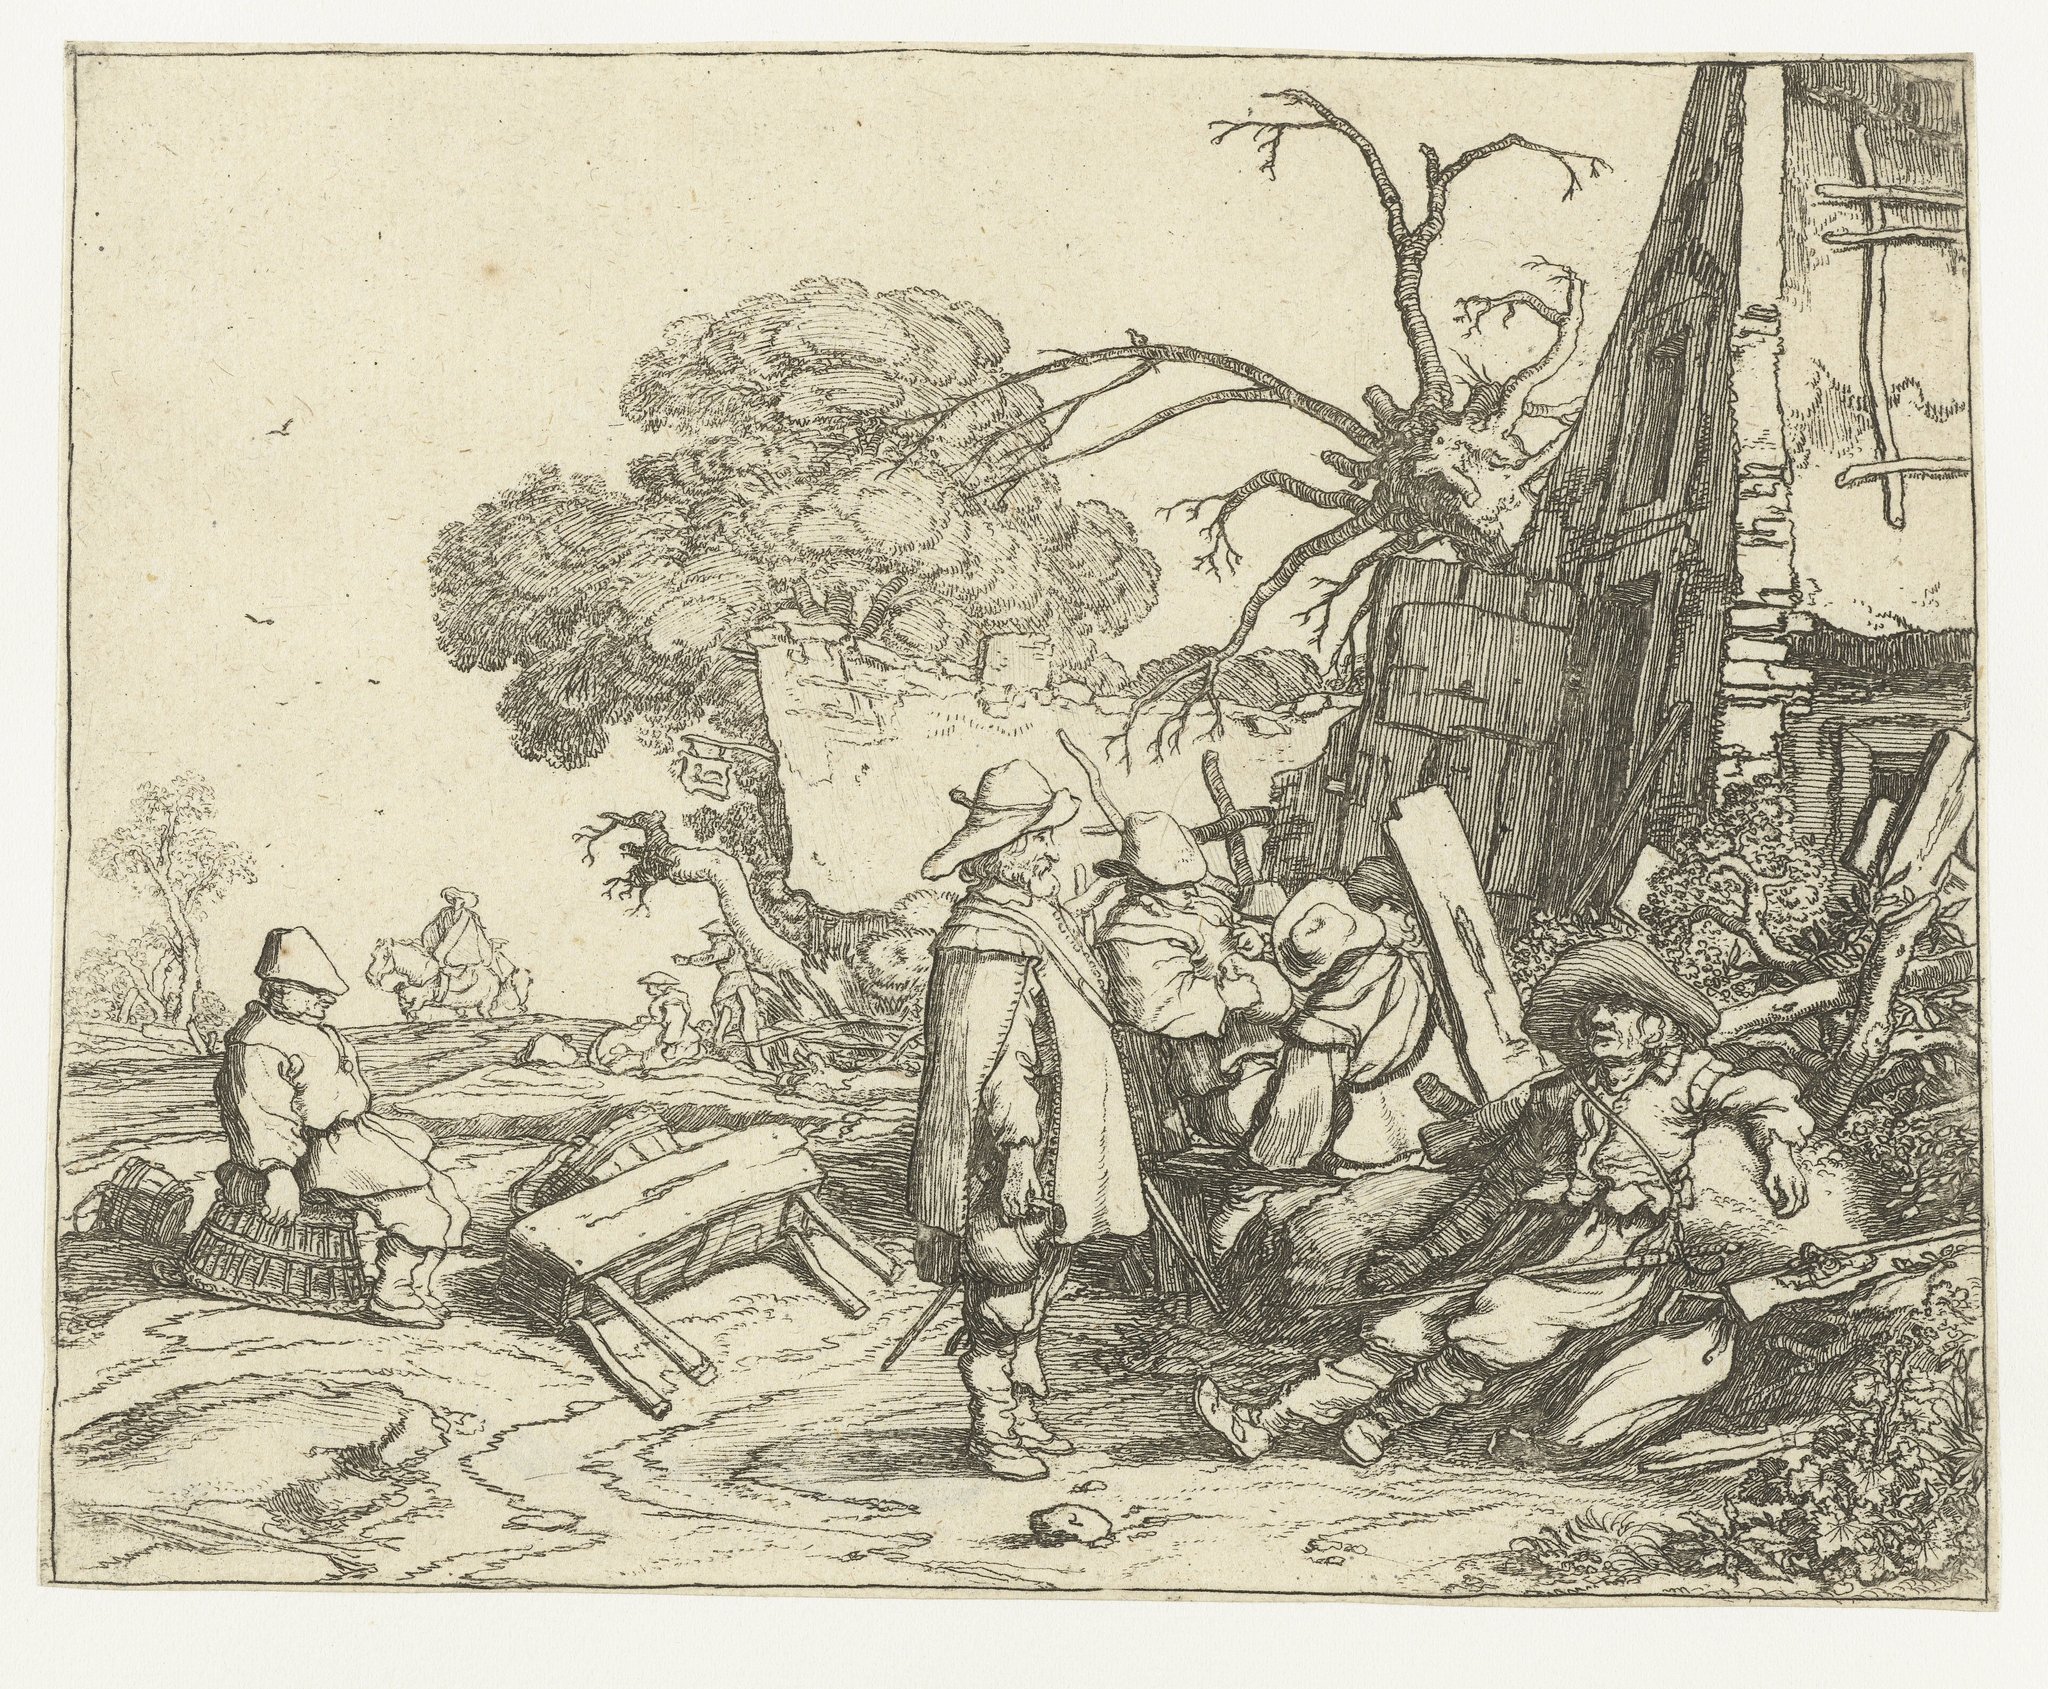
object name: print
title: Landschap met soldaten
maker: pieter de molijn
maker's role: draughtsman, painter, print maker, publisher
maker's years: 1595-1661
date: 1626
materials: paper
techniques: etching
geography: haarlem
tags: landscapes in the temperate zone, farm or solitary house in landscape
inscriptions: collector's mark: Lugt 2228a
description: In een landelijke omgeving staan en zitten soldaten bij een huis of herberg te praten. Op de achtergrond een zittende vrouw en een ruiter bij een (tweede) herberg. Deze prent is onderdeel van een serie van vier prenten van landschappen met figuren.